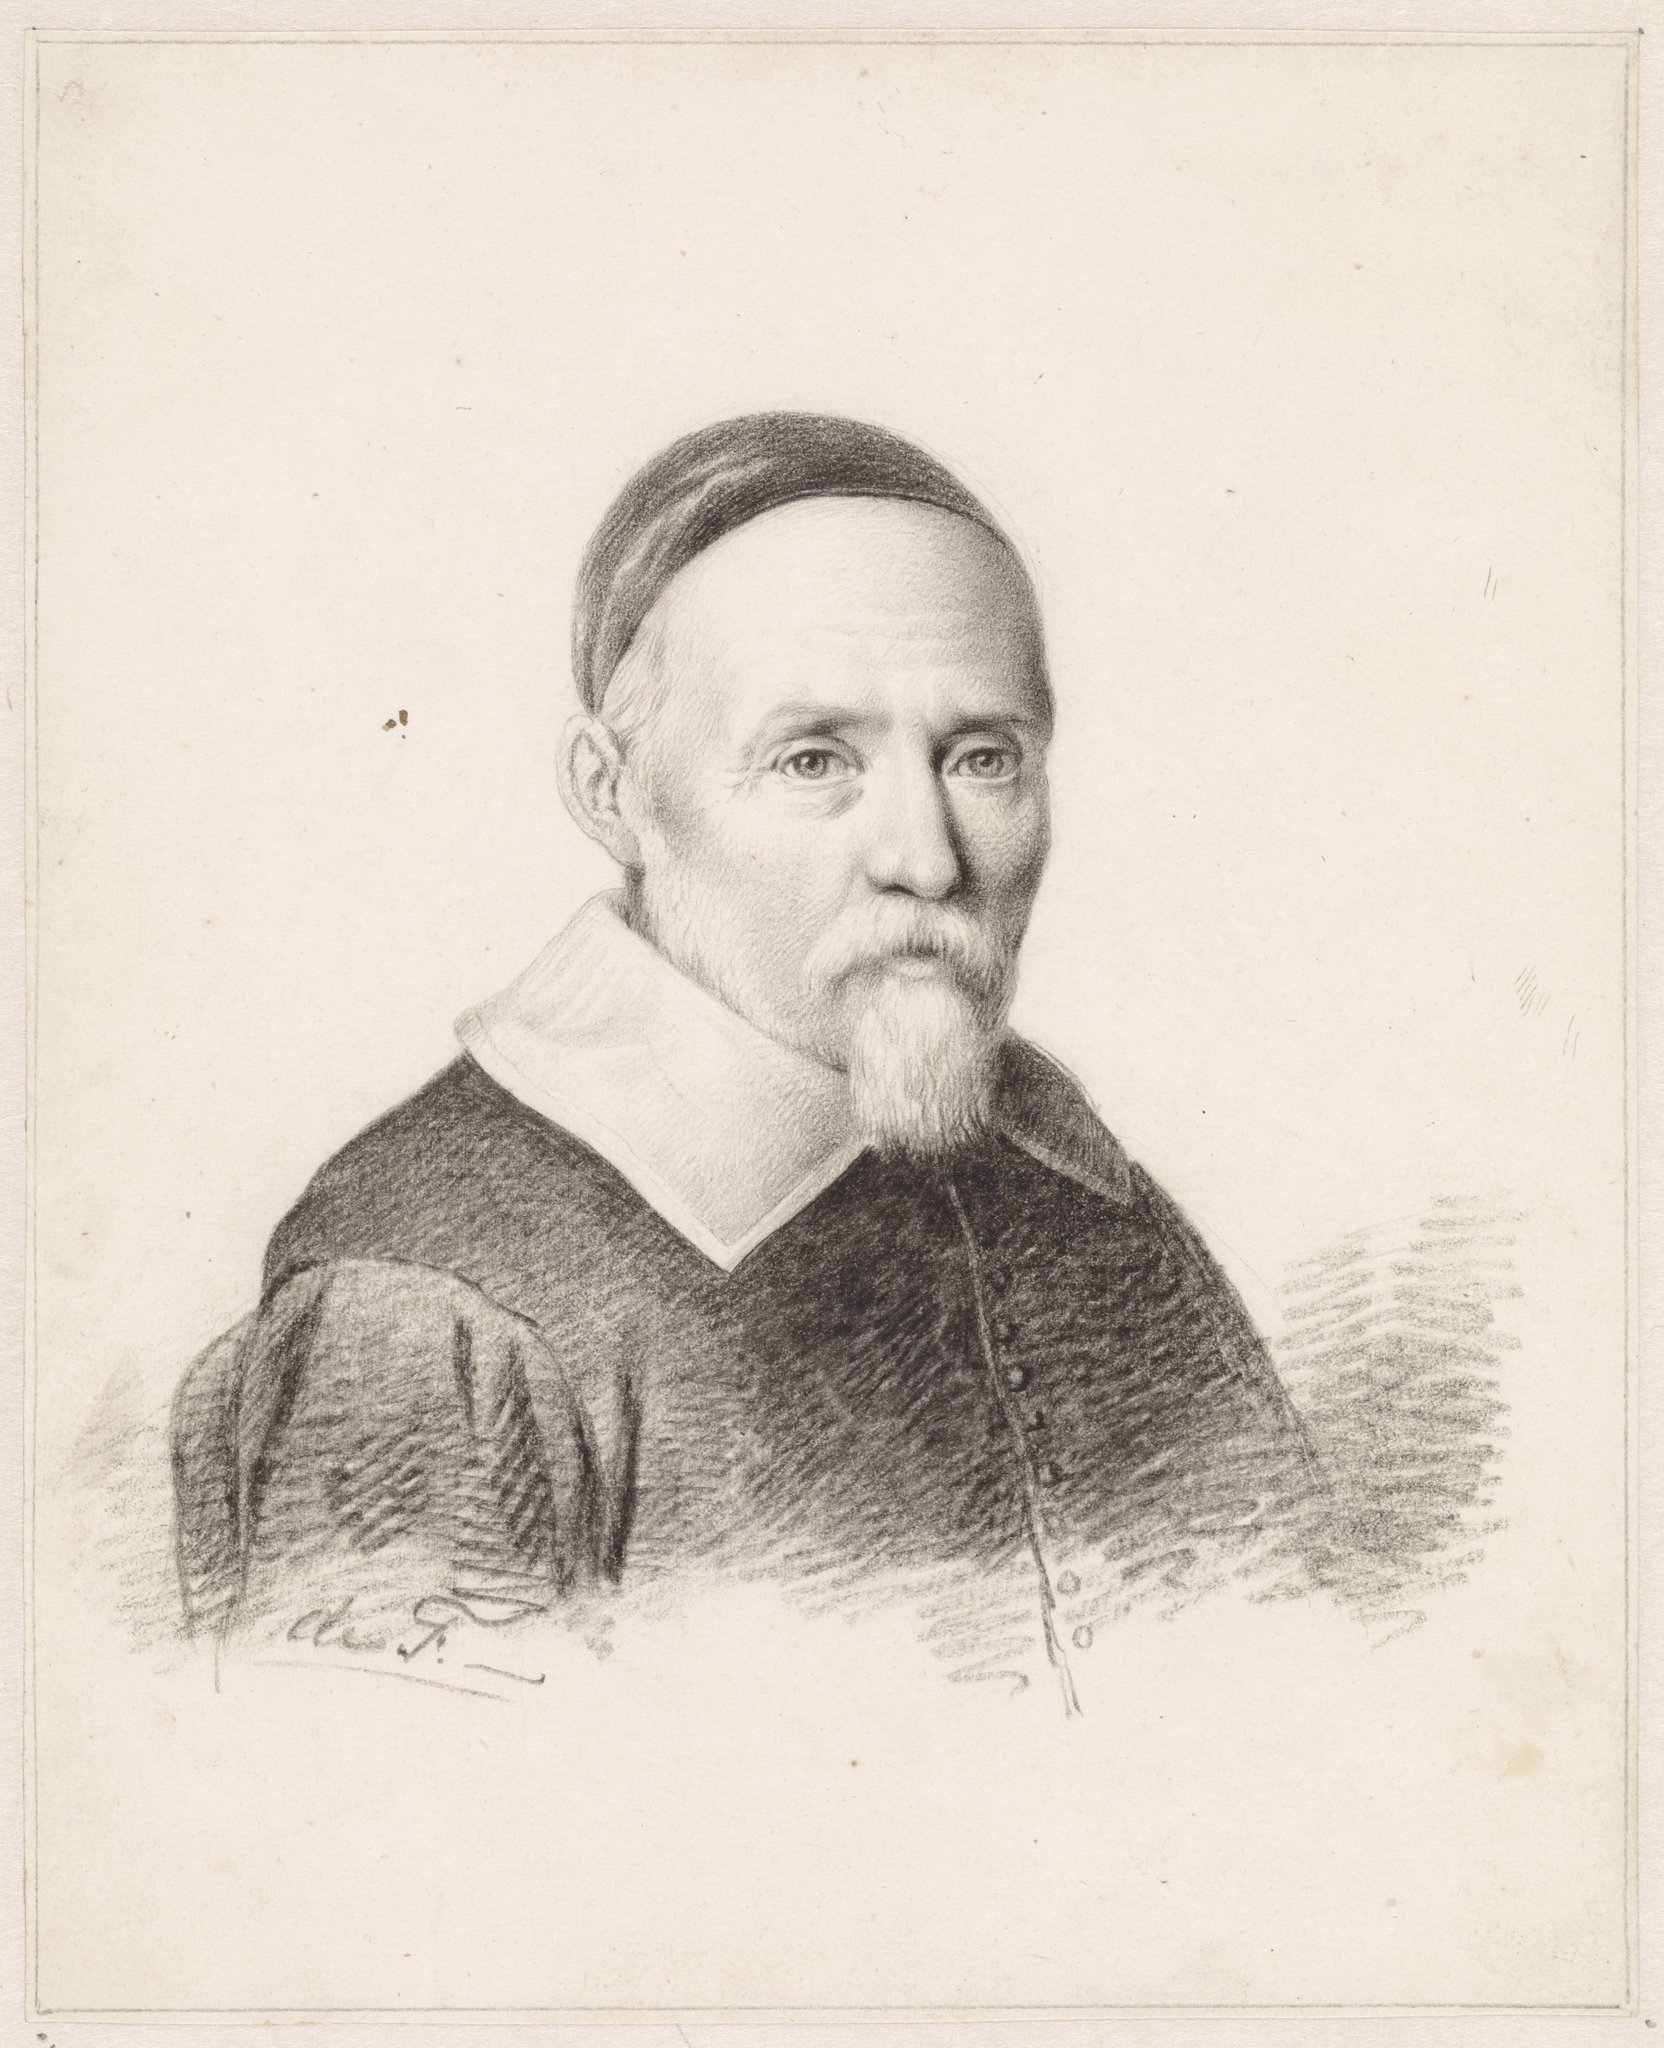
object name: drawing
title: Portret van Lodewijk de Geer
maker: louis henri de fontenay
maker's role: draughtsman, print maker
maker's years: 1800-1872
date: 1810-1852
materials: chalk, paper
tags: historical persons